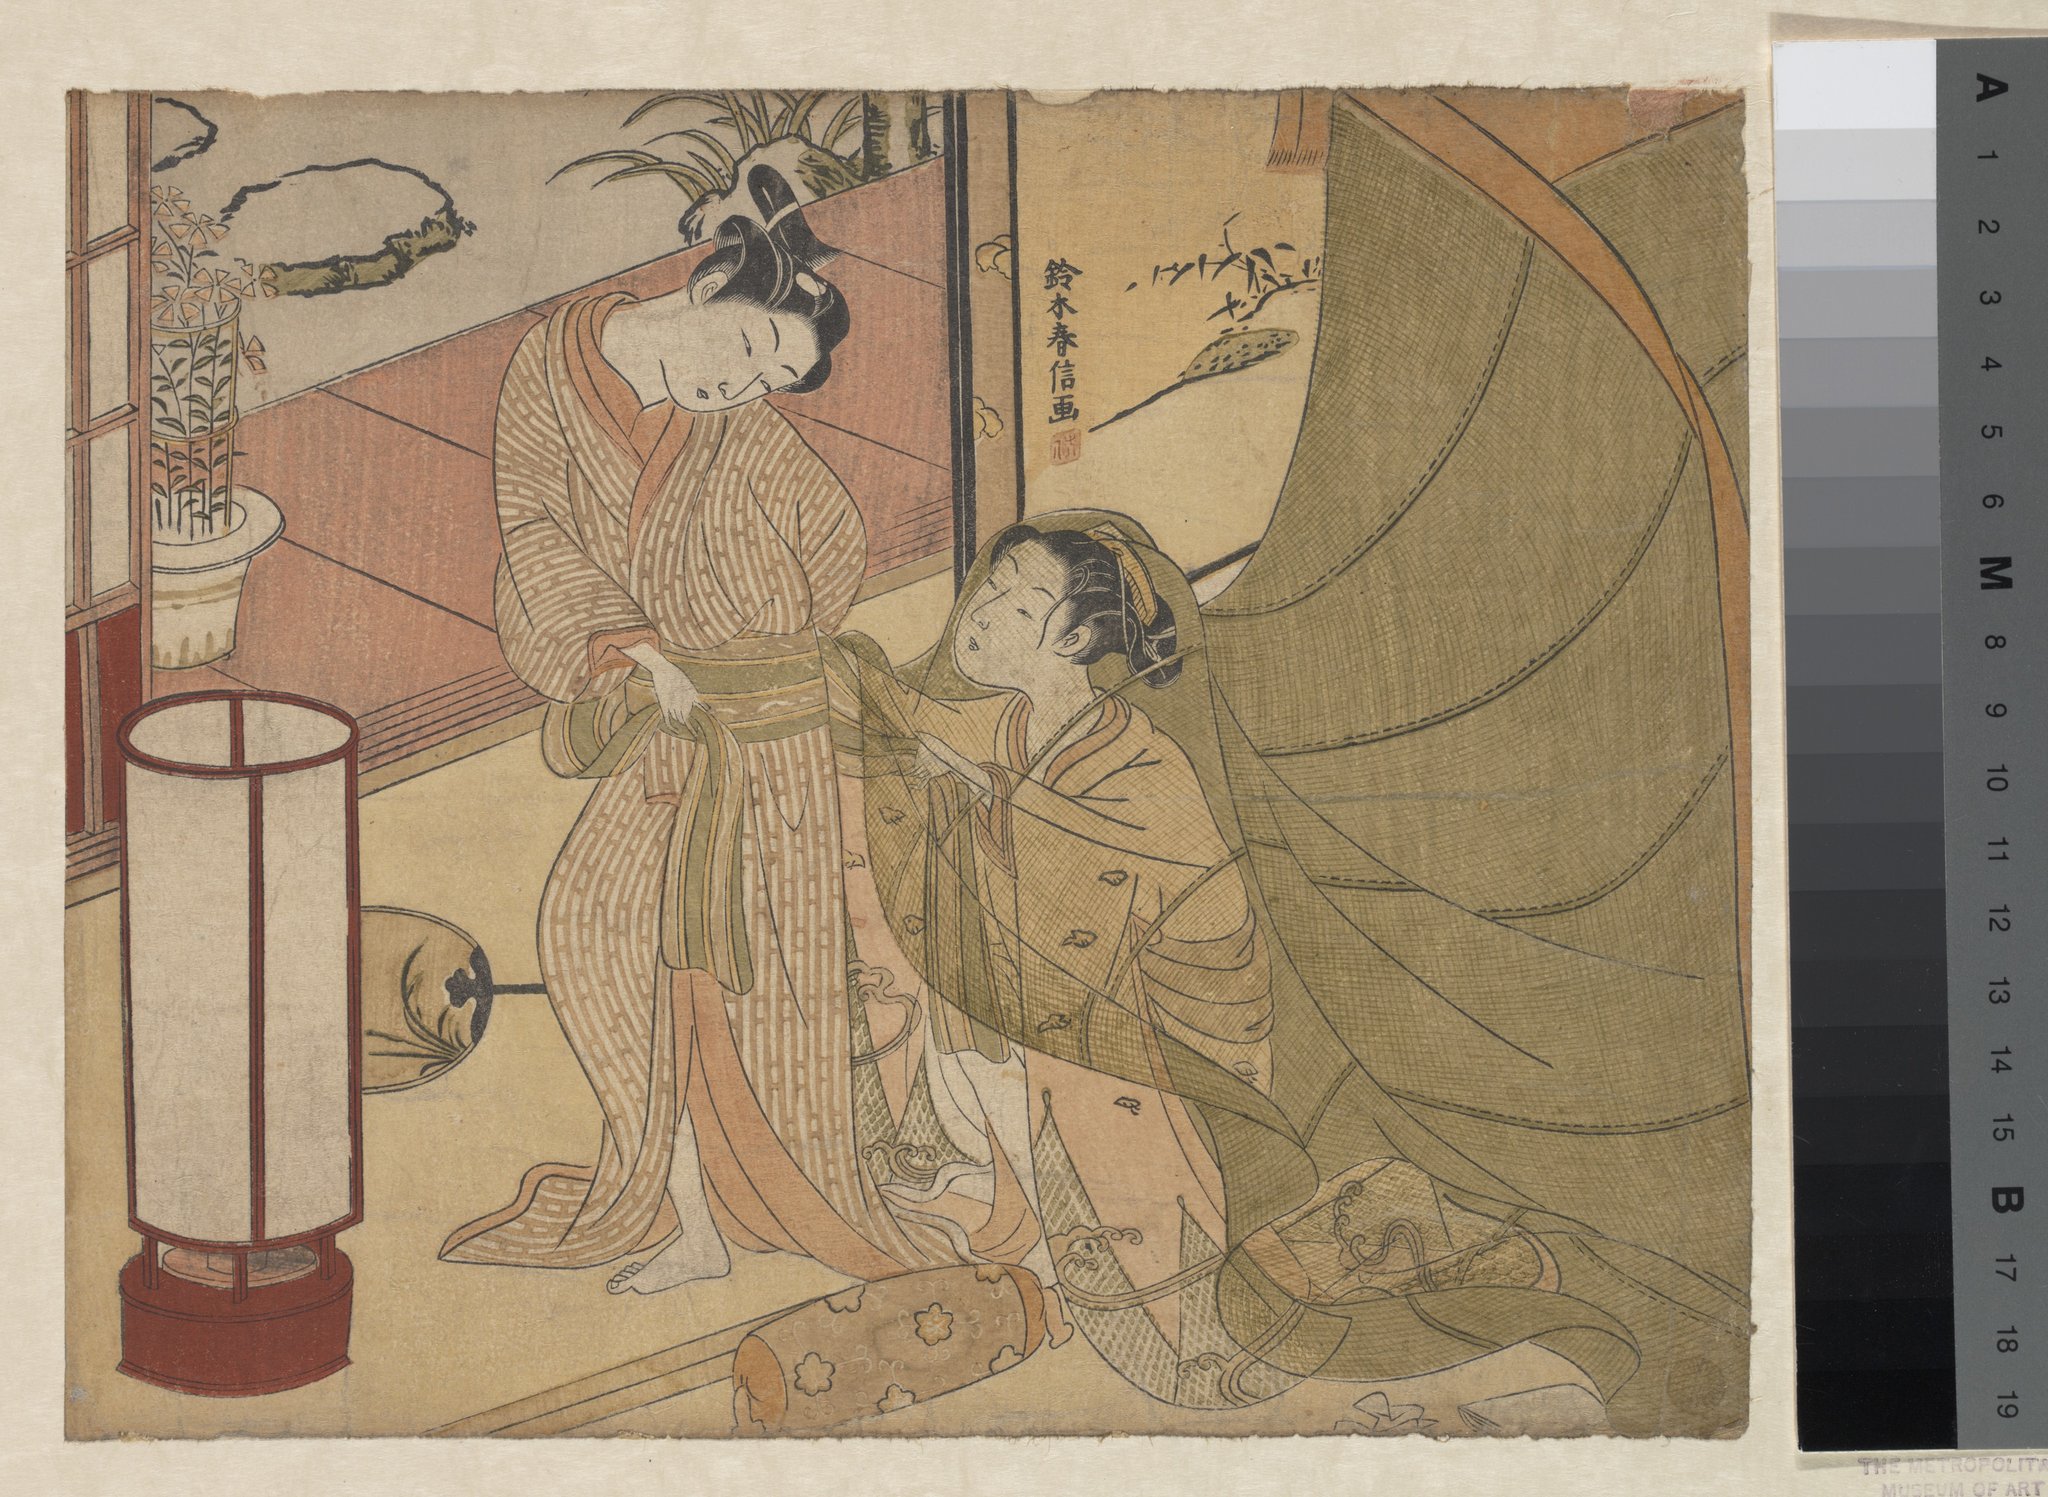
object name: print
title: Reluctant Leave-taking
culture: japanese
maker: suzuki harunobu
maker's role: artist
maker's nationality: japanese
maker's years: 1725-1770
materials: ink, paper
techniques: woodblock print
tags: women